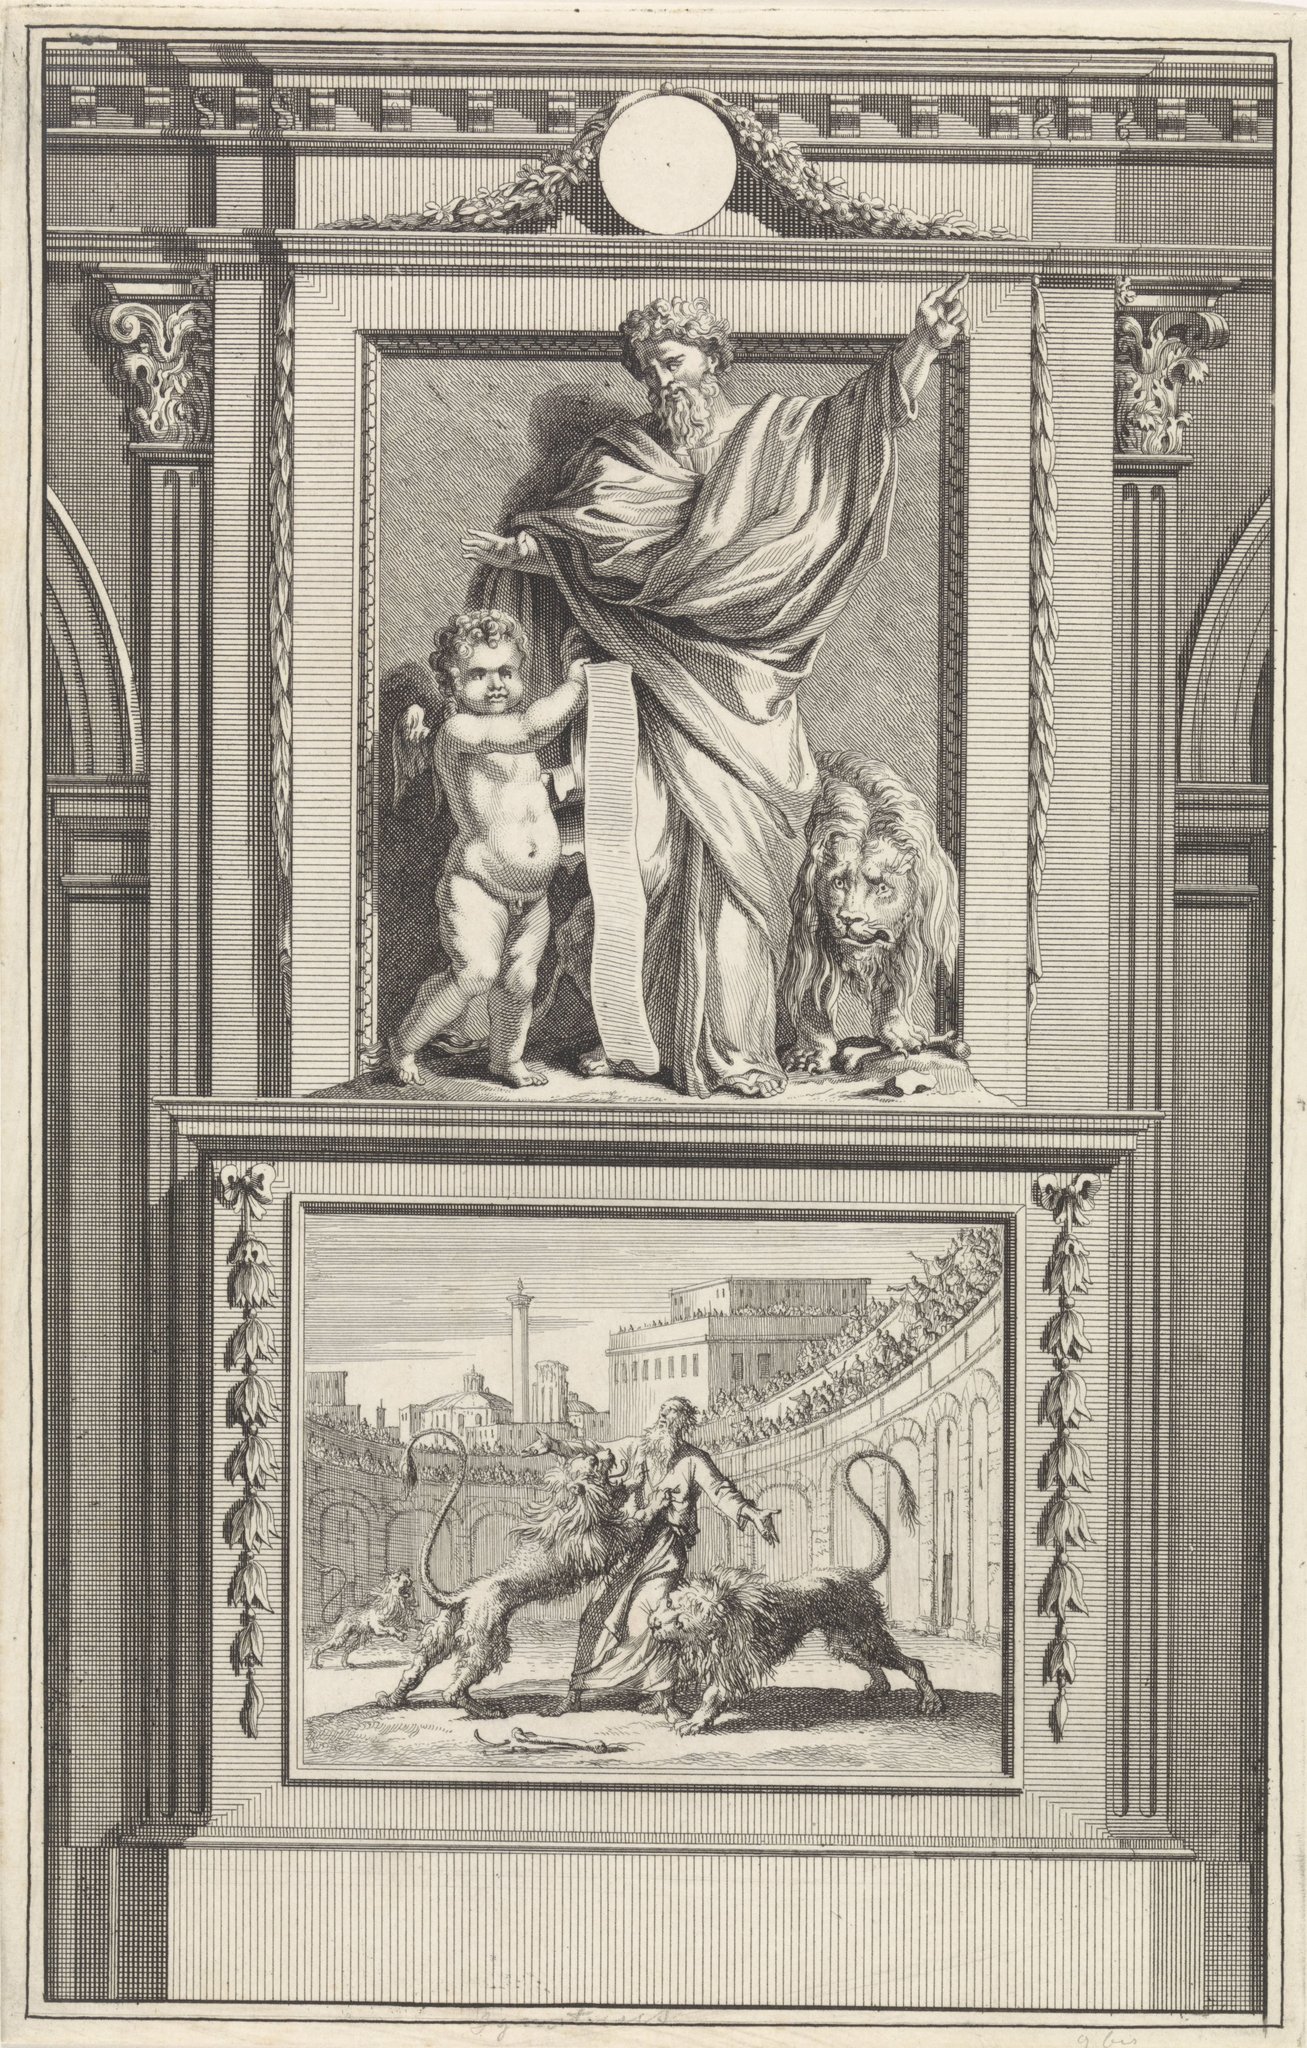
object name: print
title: H. Ignatius van Antiochië, apostolisch vader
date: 1698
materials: paper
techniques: engraving, etching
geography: amsterdam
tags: st. ignatius of antioch is thrown to the lions in the arena, the bishop of antioch, ignatius (theophoros); possible attributes: heart with ihs monogram, (two) lion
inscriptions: collector's mark: Lugt 2228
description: De heilige apostolische vader Ignatius van Antiochië wordt vergezeld door een leeuw en kijkt naar de engel die naast hem een ontrold stuk papier vasthoudt. Ignatius staat op een sokkel waar op de voorzijde in beeld is gebracht hoe hij in het Colosseum te Rome door leeuwen wordt verscheurd.